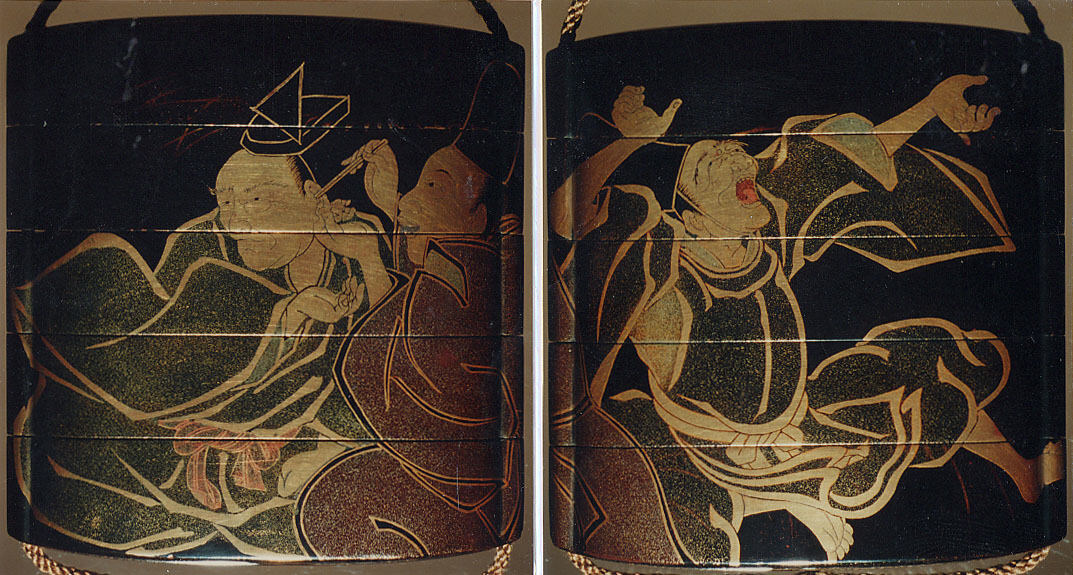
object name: inrō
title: Case (Inrō) with Design of Courtier Cleaning Another's Ear (obverse); Courtier Laughing (reverse)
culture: japanese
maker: kajikawa hidetaka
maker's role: artist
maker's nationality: japanese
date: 1701-1900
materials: gold, lacquer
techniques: fundame, roiro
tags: men